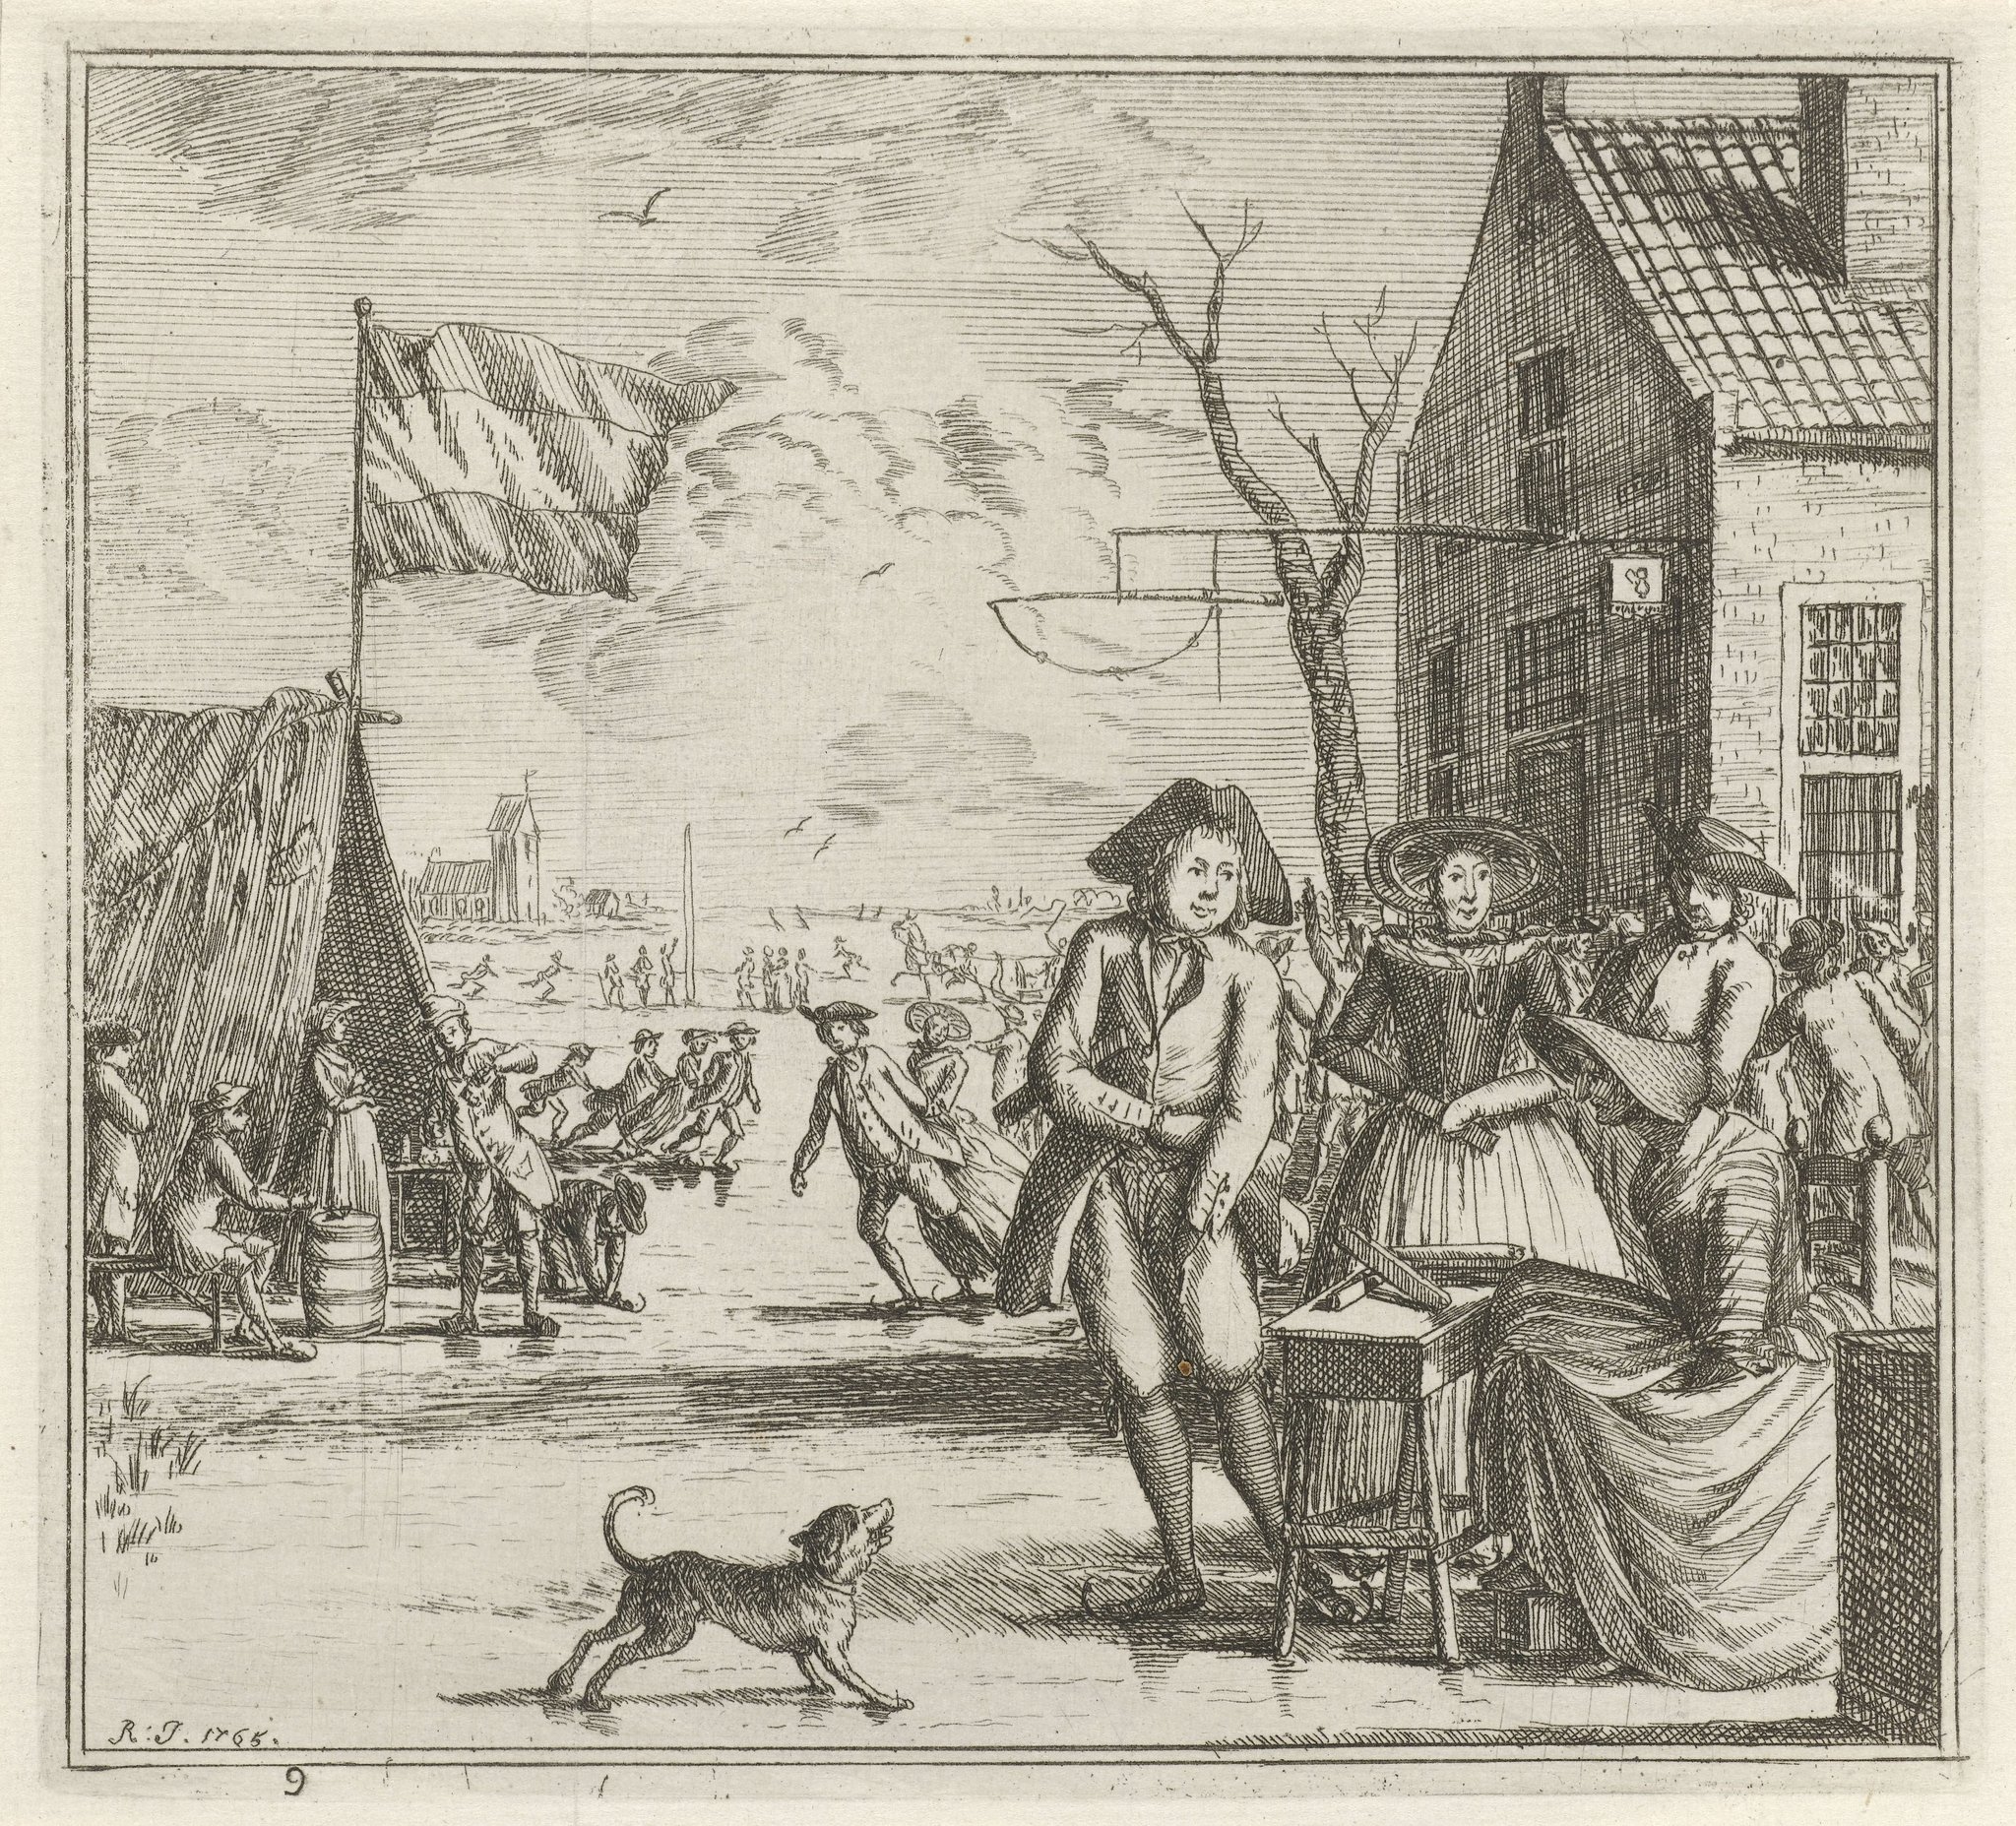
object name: print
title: Winterlandschap met herberg en schaatsers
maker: rienk jelgerhuis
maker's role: draughtsman, print maker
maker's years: 1729-1806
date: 1765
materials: paper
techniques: engraving, etching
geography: leeuwarden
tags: inn, coffee-house, public house, etc., stall, booth (~ market), skates (winter sports)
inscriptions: collector's mark: Lugt 2228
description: Winterlandschap met een vrouw met koopwaar, twee mannen en een vrouw. Links een tent met etende en drinkende mensen. Prent uit een serie van dertien met wintertaferelen.